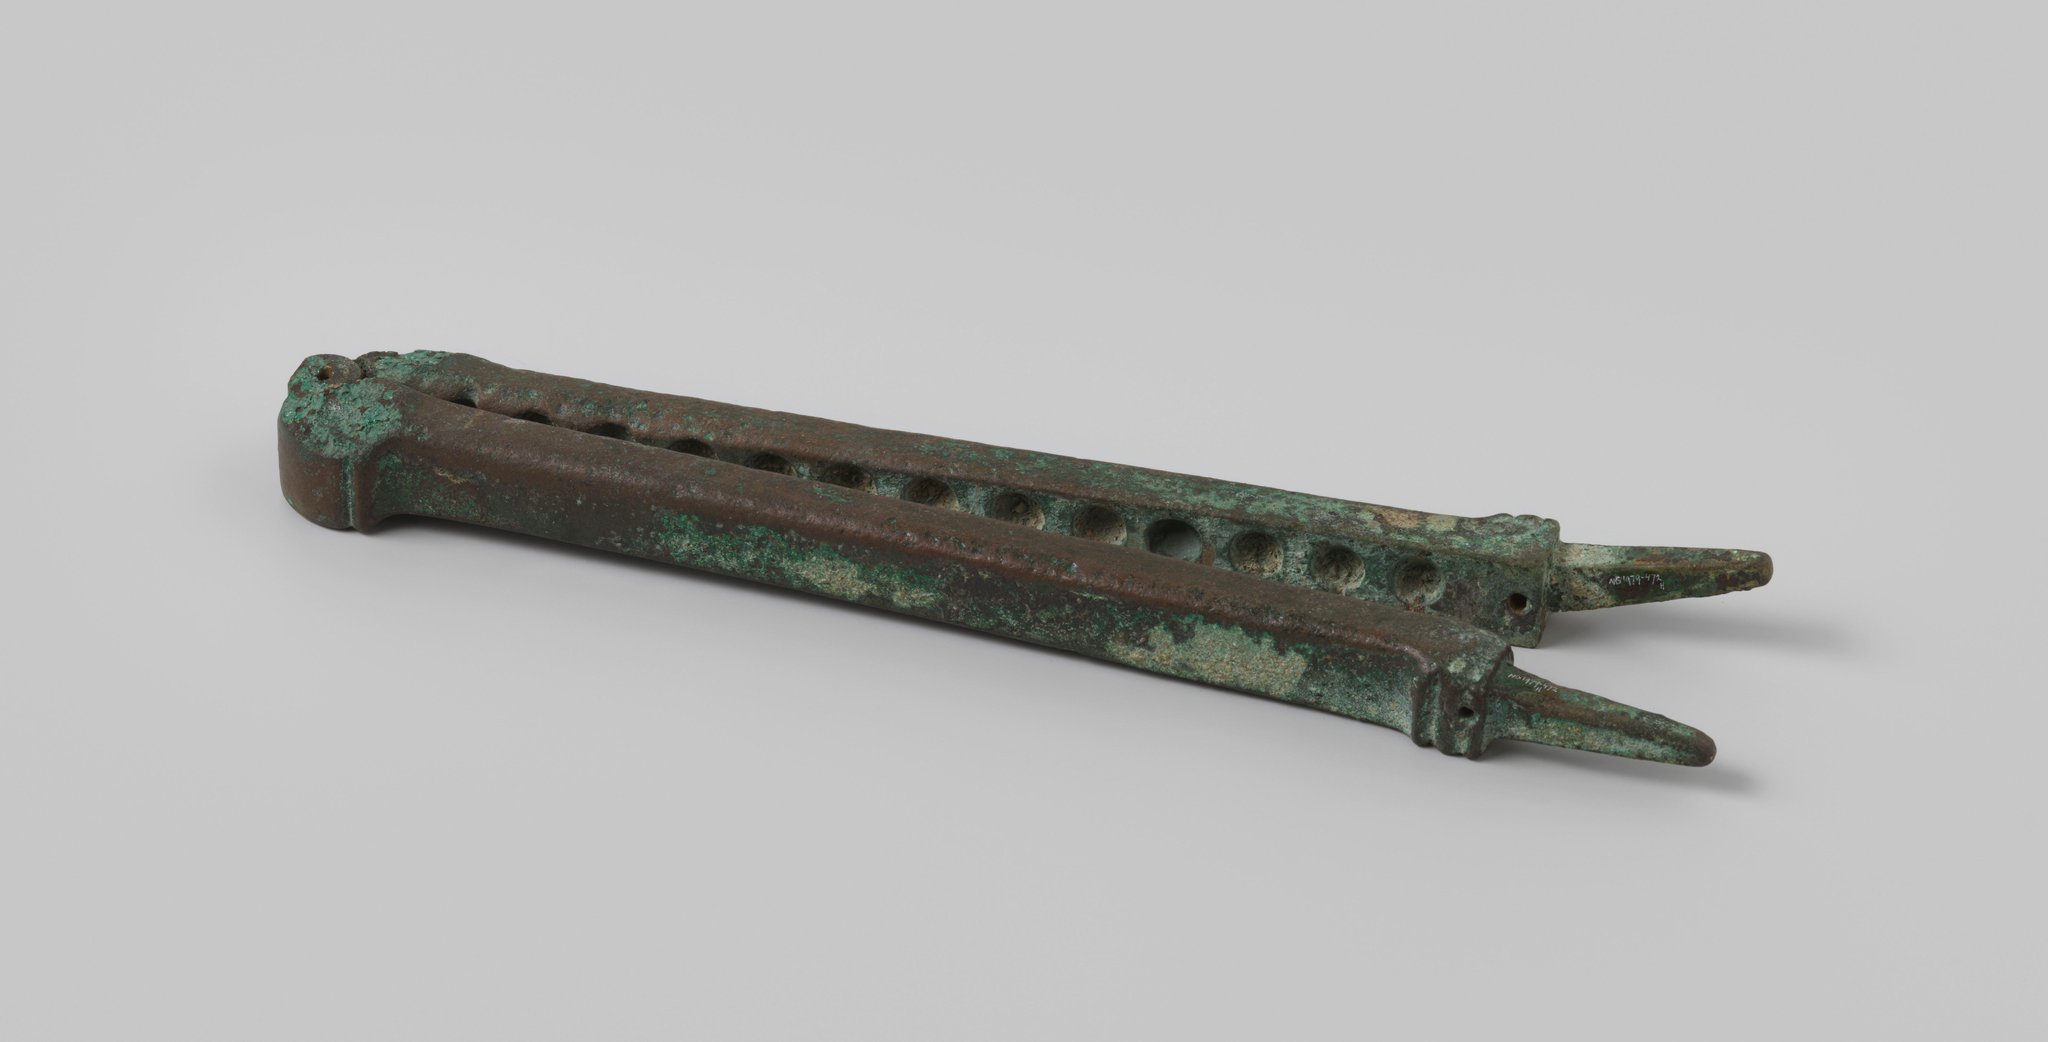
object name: bullet mould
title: Giettang voor musketkogels uit het wrak van de Oost-Indiëvaarder Hollandia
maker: Anonymous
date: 1700-1743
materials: copper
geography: netherlands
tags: verenigde oostindische compagnie, hollandia (schip), annet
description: Met deze bronzen kogeltang kunnen 13 loden kogels tegelijk worden gegoten. De diameter van de kogels is 16 mm (zijn kogels van 14 in 't pond, het standaardkaliber voor VOC-musketten).